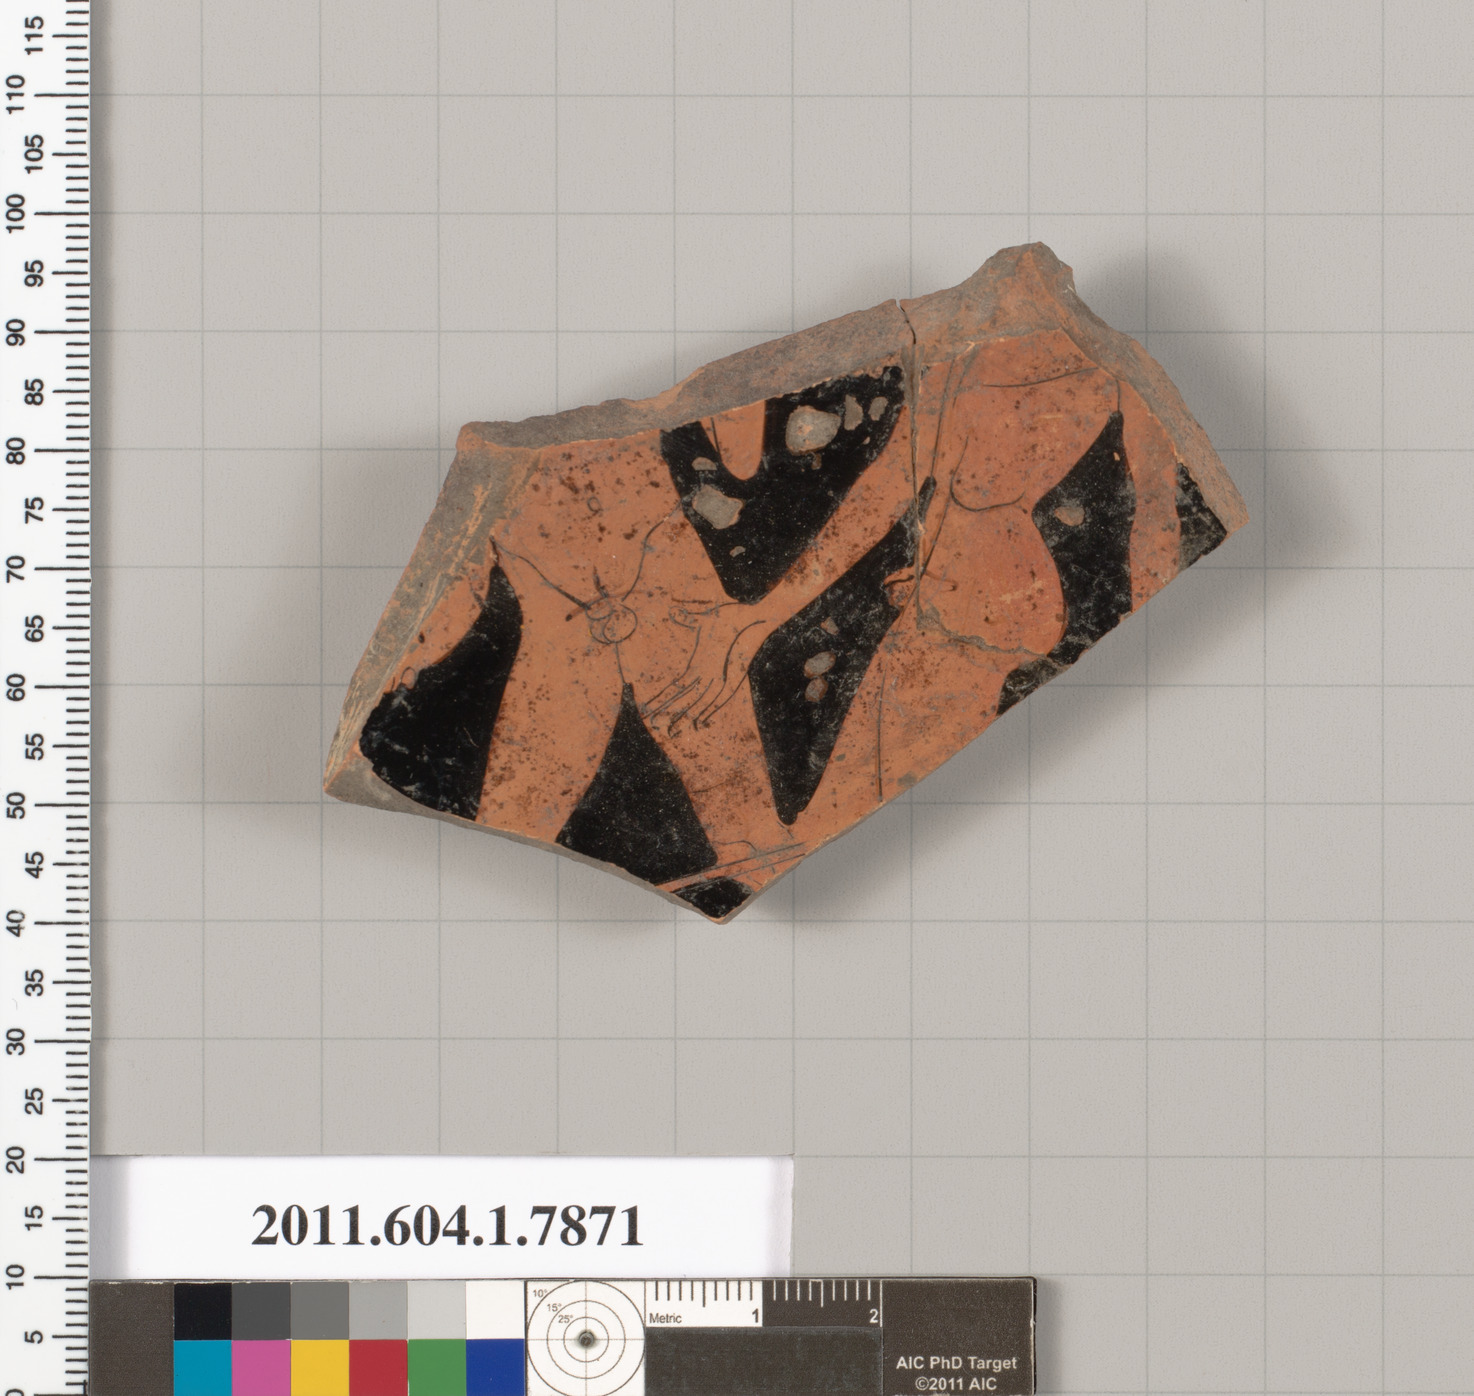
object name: kylix fragment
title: Terracotta fragment of a kylix (drinking cup)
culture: greek, attic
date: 440-420 BCE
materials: terracotta